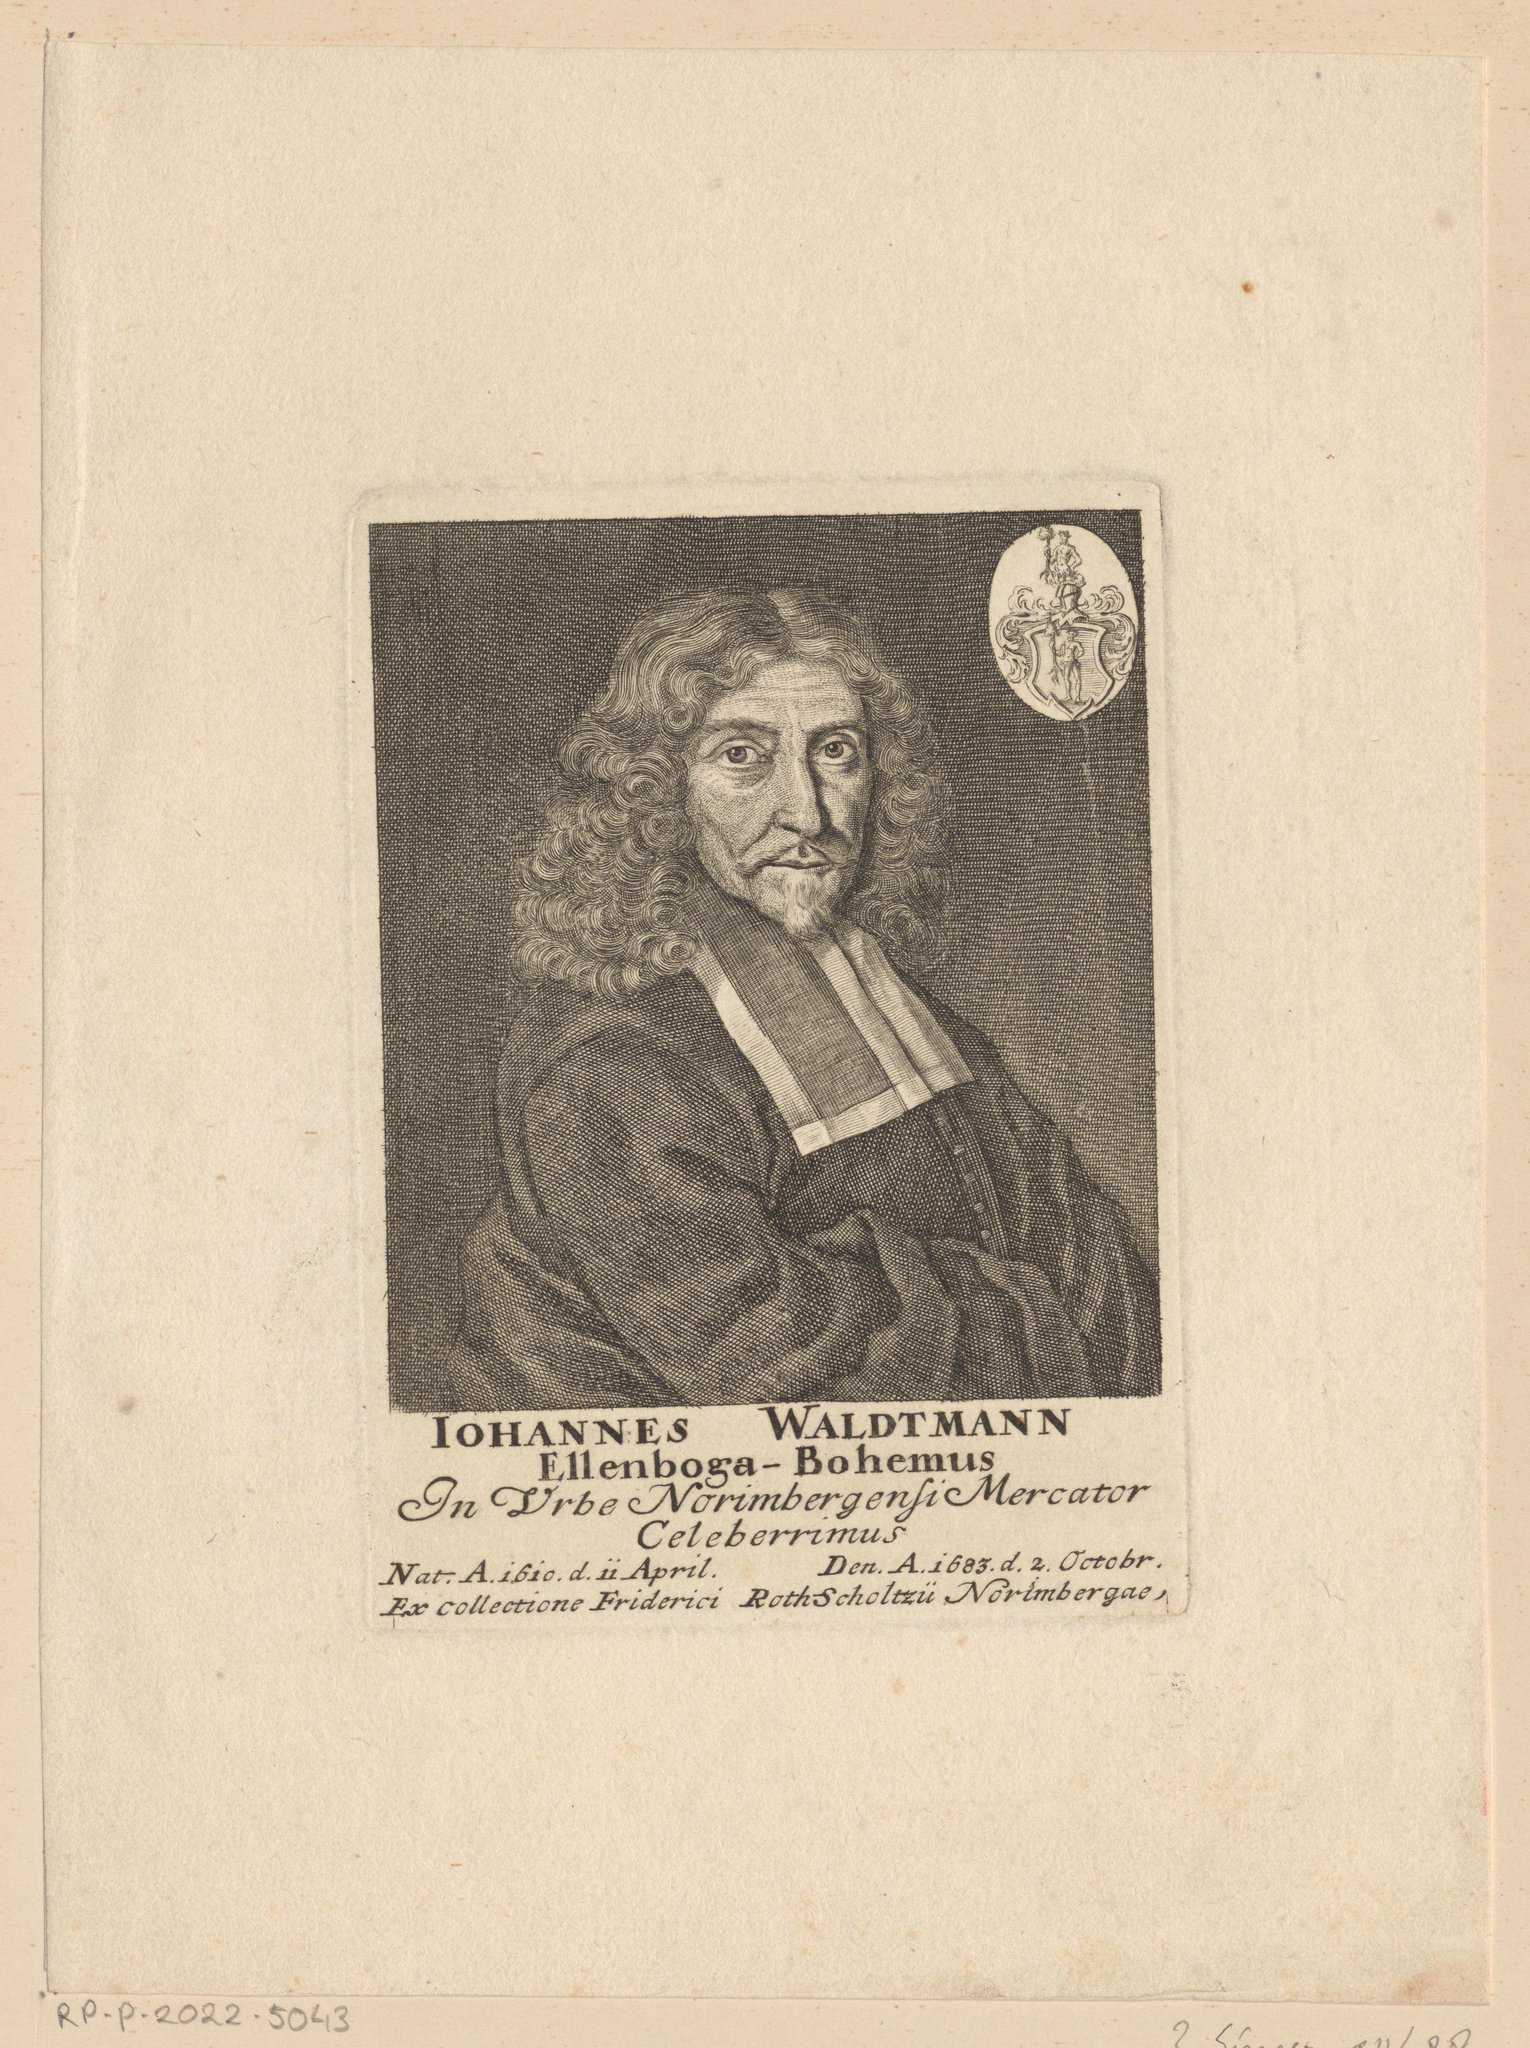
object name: print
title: Portret van Johann Waldtmann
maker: Anonymous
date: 1720-1770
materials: paper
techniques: engraving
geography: germany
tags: historical persons, armorial bearing, heraldry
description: Met vierregelig onderschrift in het Latijn.